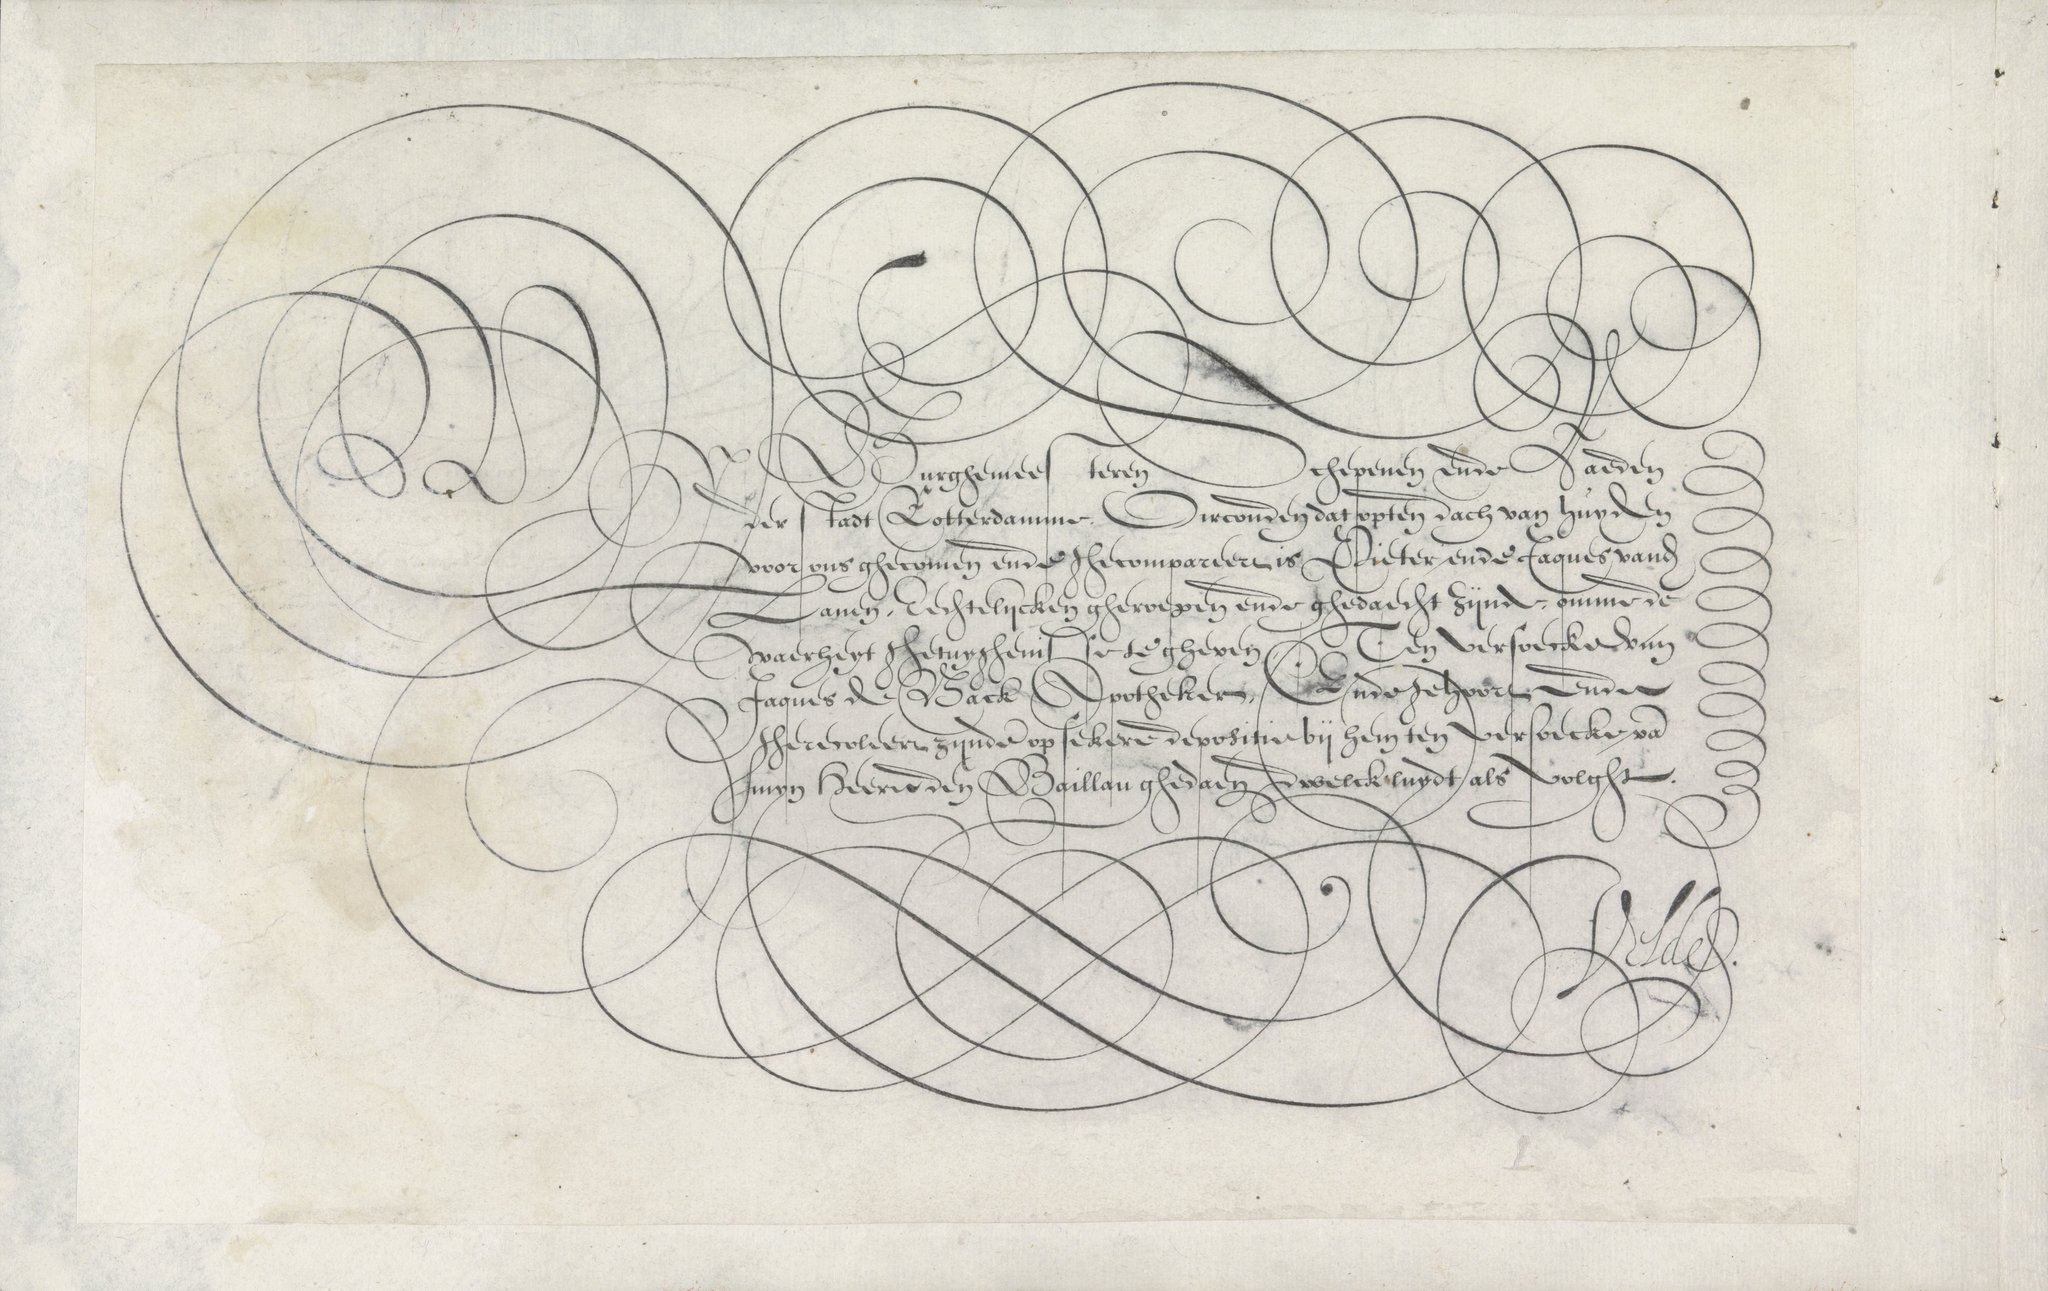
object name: drawing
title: Ontwerp van een schrijfvoorbeeld: De Burgehemeesteren (...)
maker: jan van de velde (i)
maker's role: painter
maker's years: 1568-1623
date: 1605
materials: ink, paper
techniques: calligraphy, pen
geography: rotterdam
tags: calligraphy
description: Kalligrafische tekening met acht regels tekst in het Nederlands: De Burghemeesteren Schepenen ende Raeden der stadt Rotterdamme ... De tekst is omlijst door krulwerk. De tekening maakt deel uit van een album.